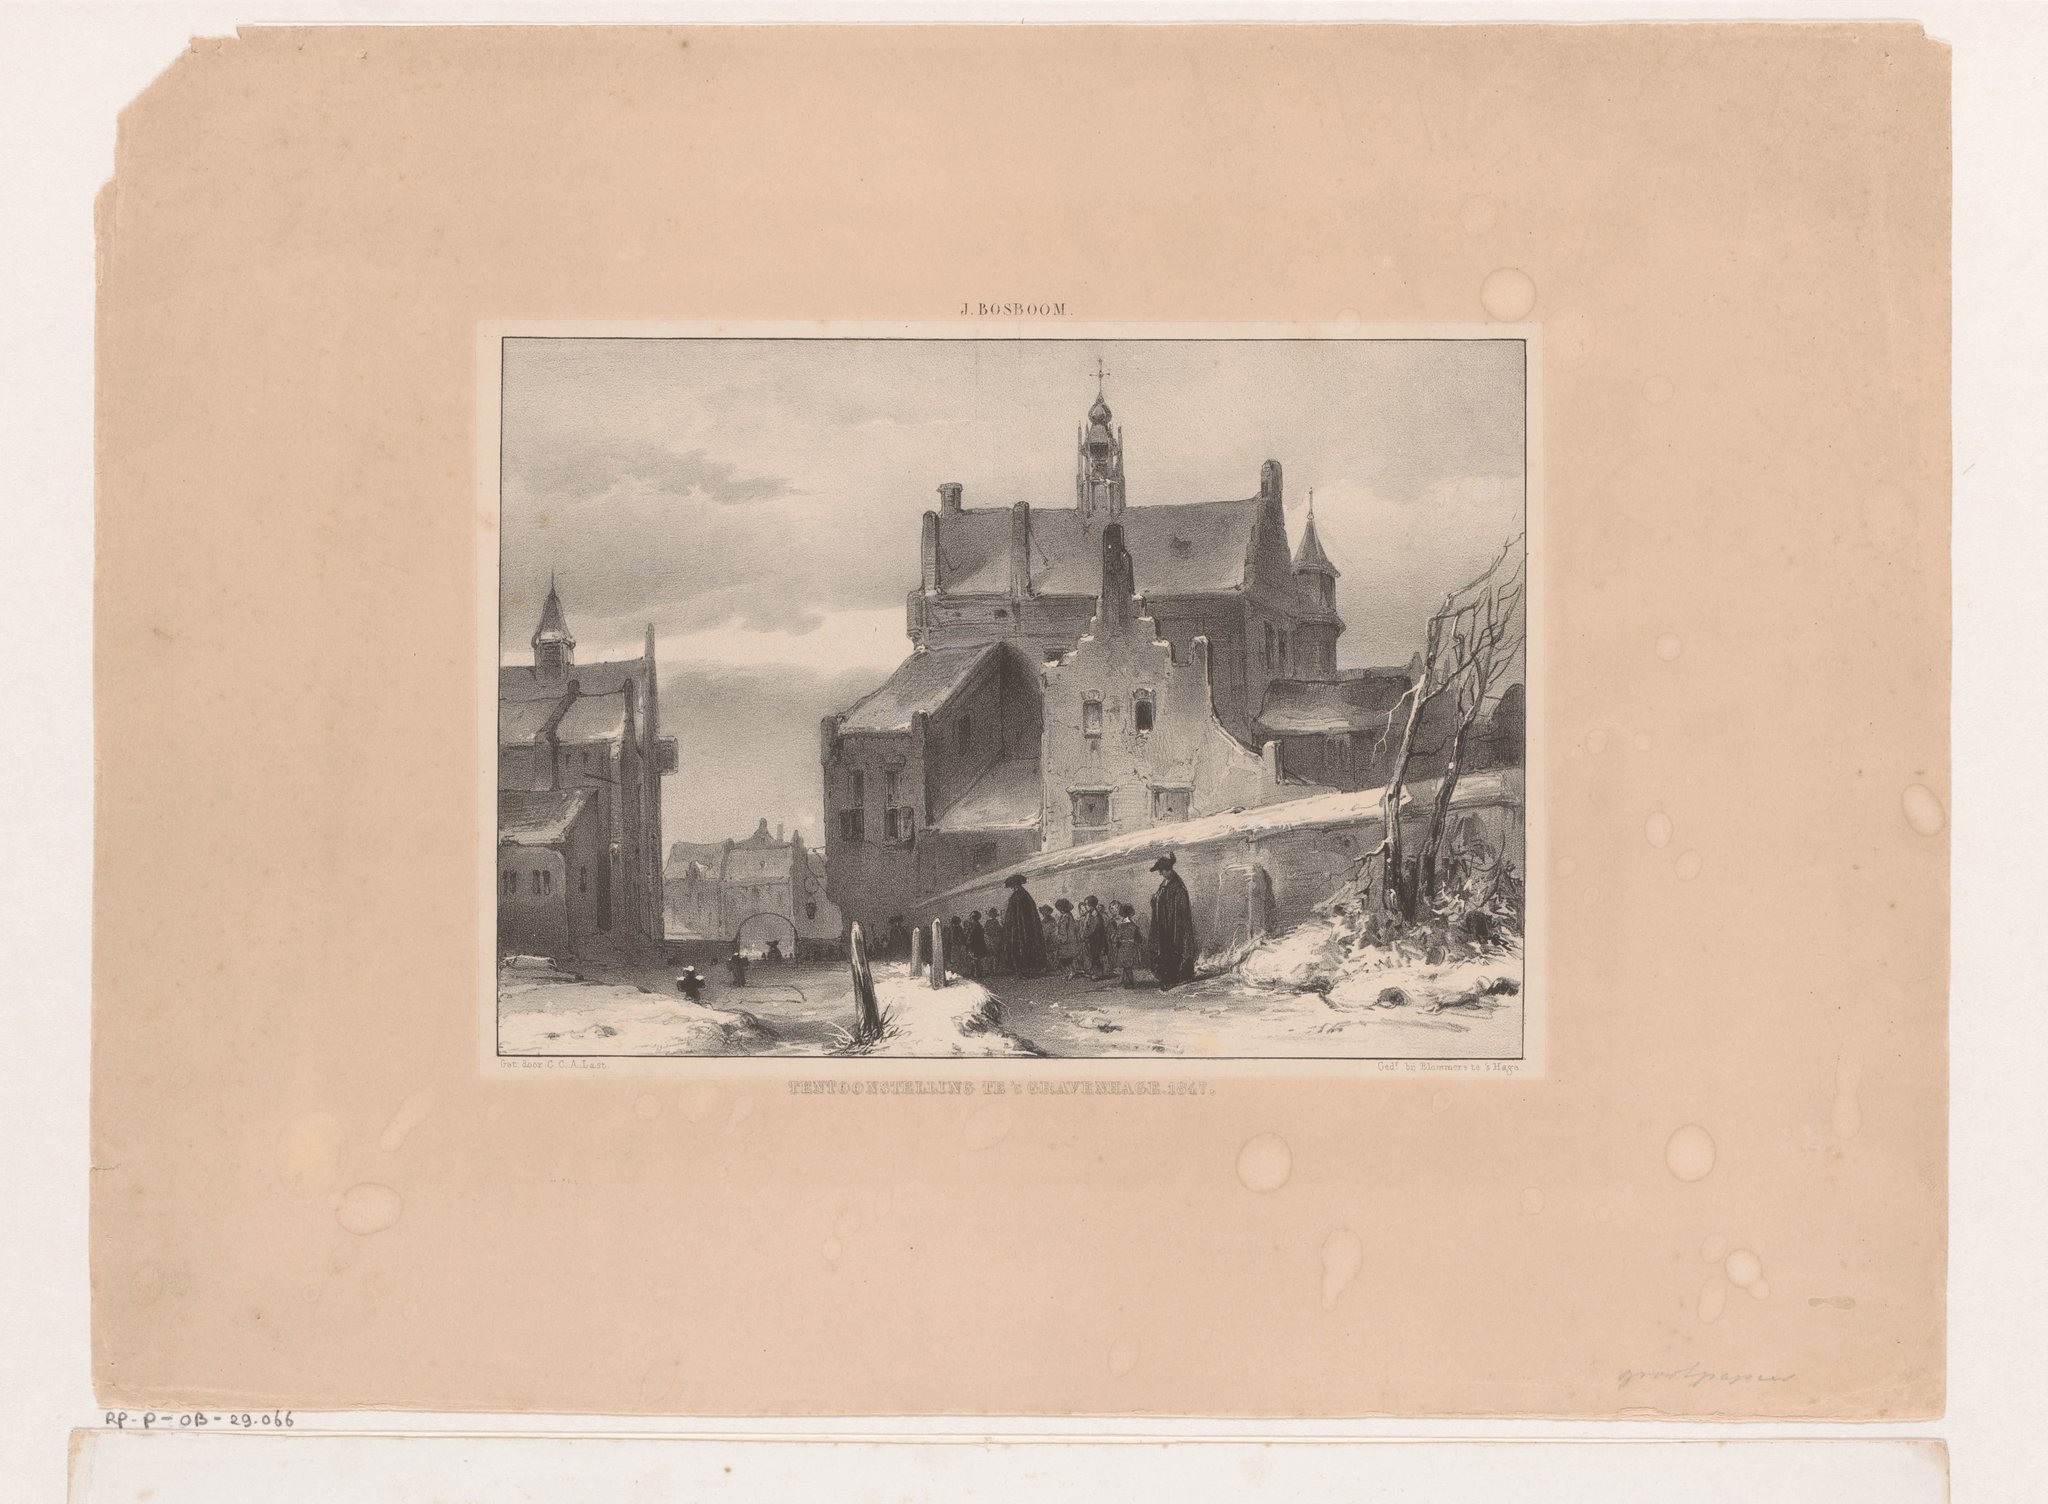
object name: print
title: Wintergezicht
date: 1842-1887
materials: paper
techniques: lithograph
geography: the hague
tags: child, church (exterior), winter landscape; landscape symbolizing winter (the four seasons of the year), street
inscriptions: collector's mark: Lugt 2228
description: Op straat loopt een groep kinderen, mogelijk school- of weeskinderen, onder begeleiding van enkele mannen. Verderop een kerk.